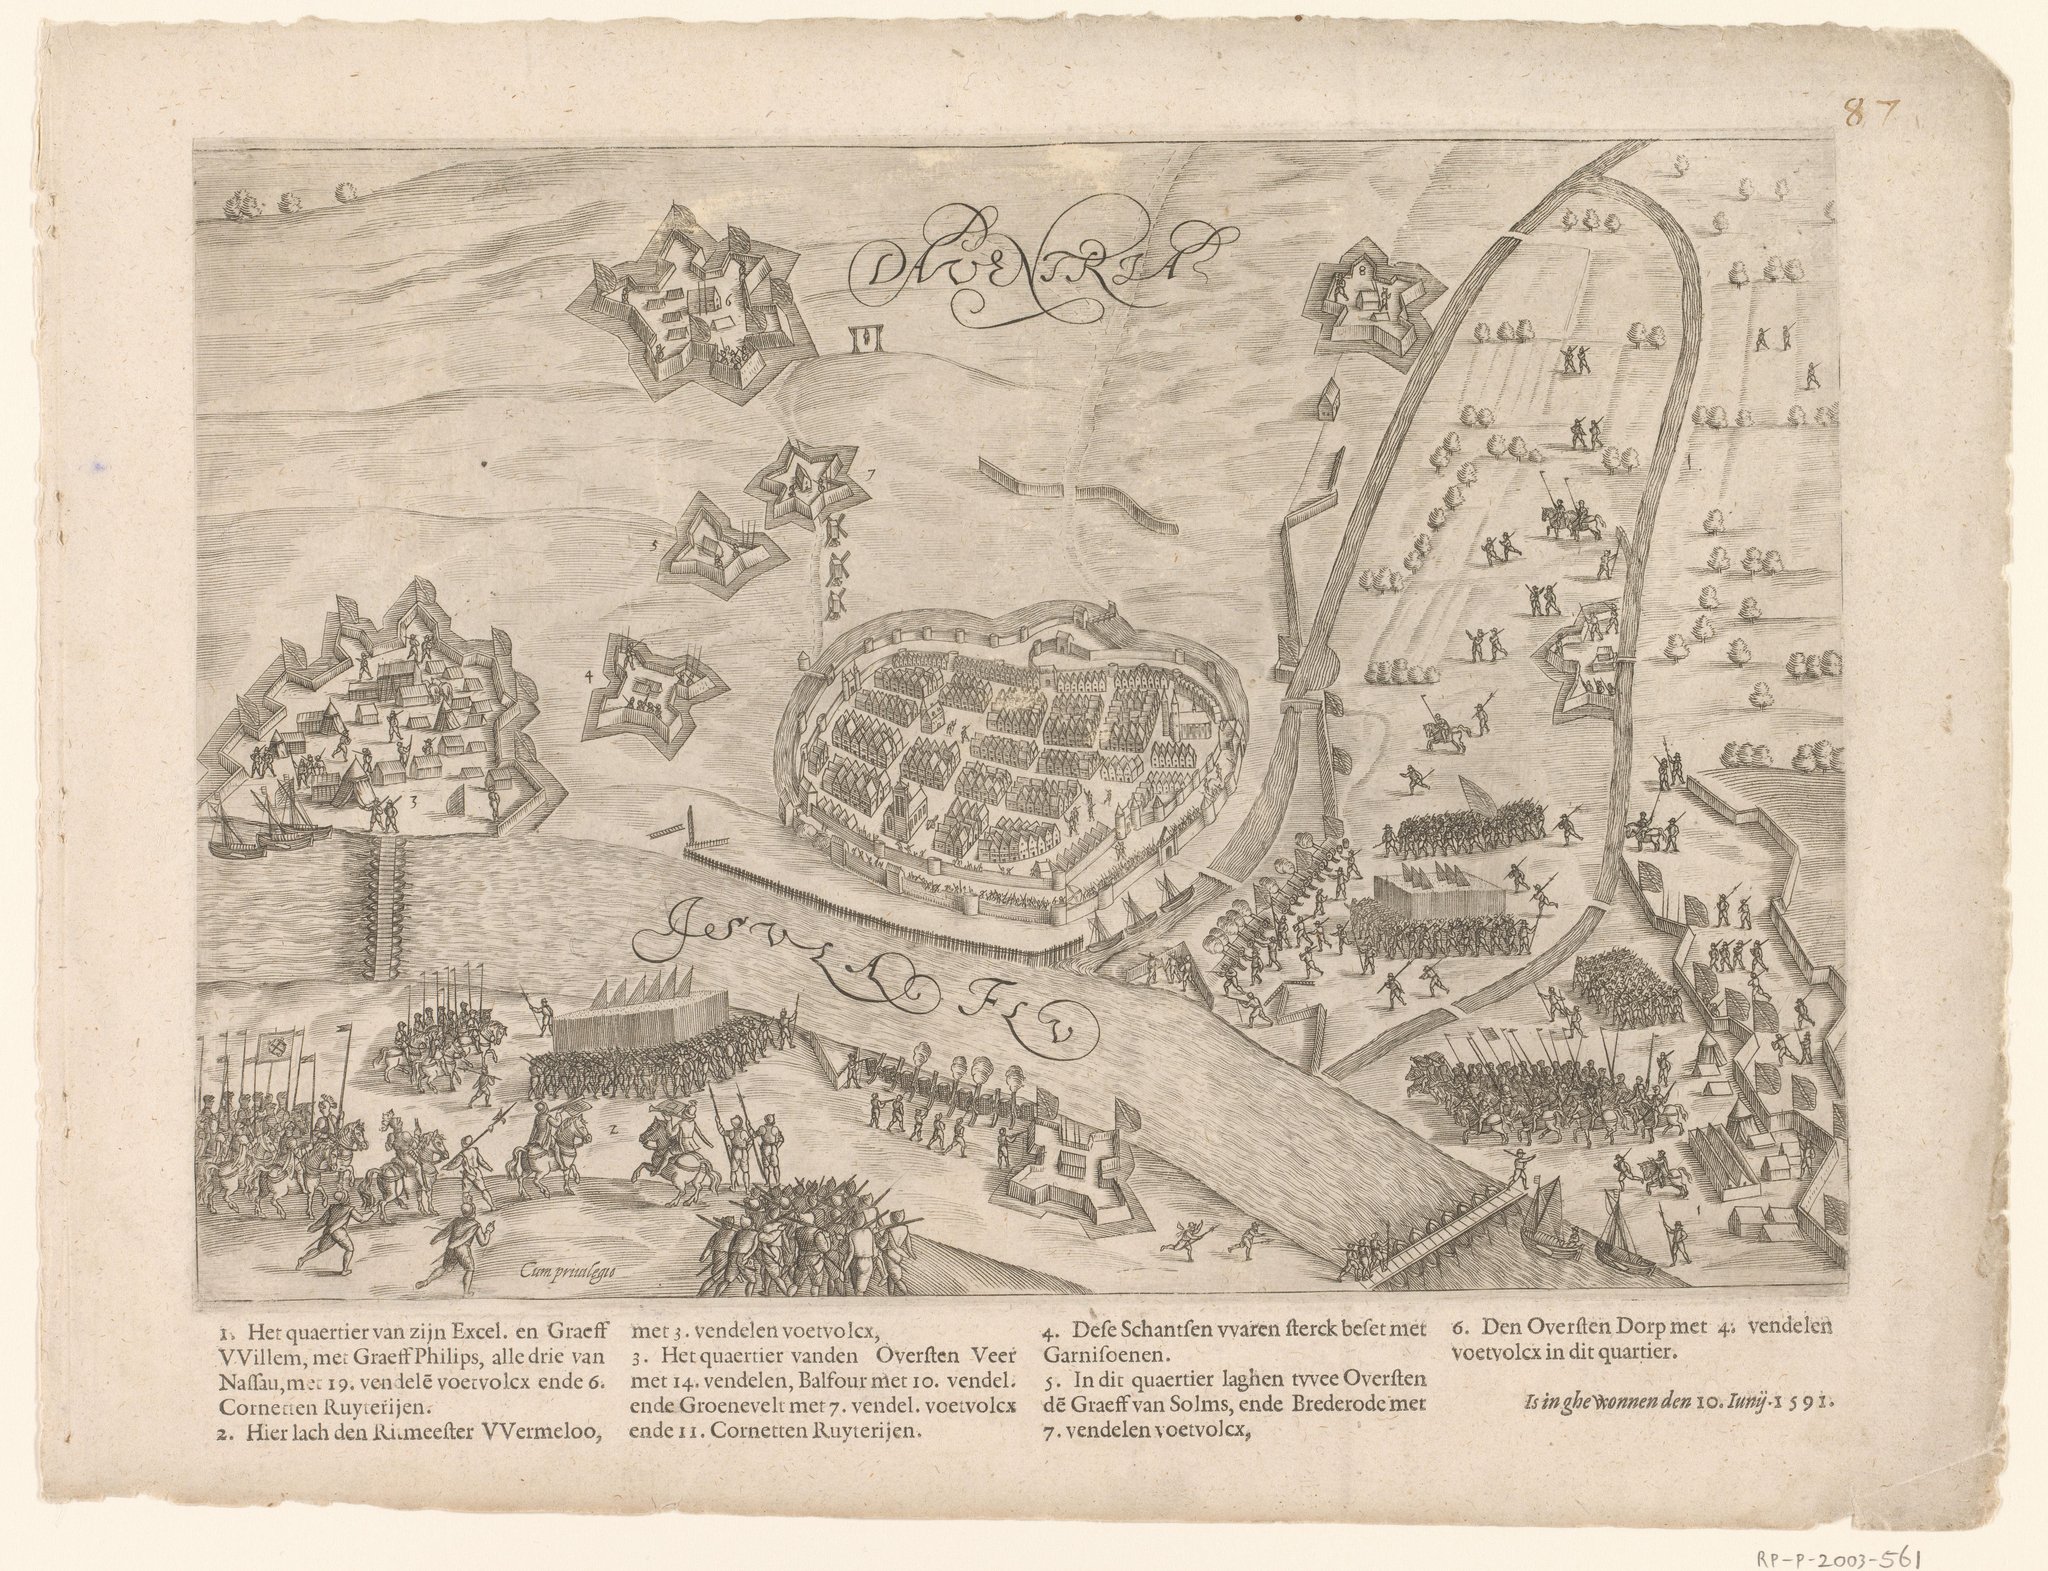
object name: print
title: Daventria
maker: pieter bast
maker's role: print maker, publisher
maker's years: 1570-1605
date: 1608-1610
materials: paper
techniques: engraving, letterpress printing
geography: northern netherlands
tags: the hague, maurice (prince of orange), improvised bridge, temporary bridge ~ military engineering, capture of city (after the siege), maps of cities, deventer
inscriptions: number: ‘87’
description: Beleg en inname van Deventer door het Staatse leger onder Maurits, 10 juni 1591. Plan van Deventer en het omringende land met schansen en wallen. Met twee schipbruggen over de IJssel. Apart gedrukt onder de plaat de legenda 1-6 in vier kolommen in het Nederlands. Aan het eind van de tekst het opschrift 'Is in ghe wonnen den 10. Iunij. 1591'. Onderdeel van de verzameling kaarten genomen uit een latere editie van: Descrittione di tutti i Paesi Bassi van Lodovico Guicciardini.